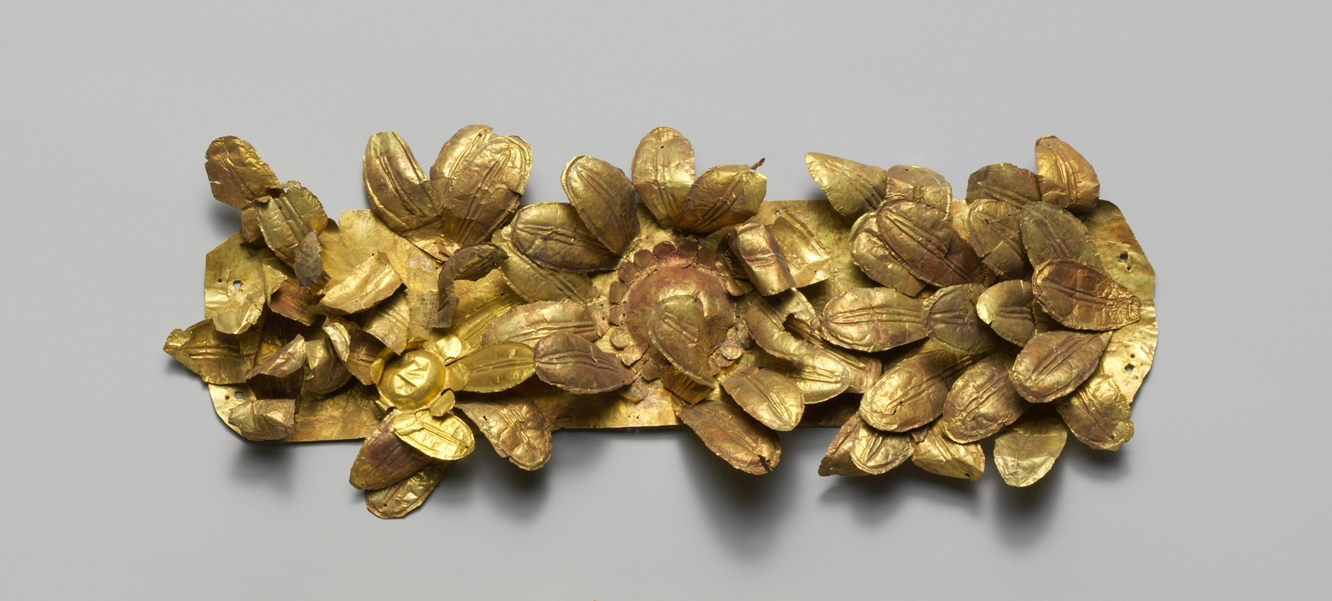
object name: wreath, funerary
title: Gold wreath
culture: etruscan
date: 400-201 BCE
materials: gold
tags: flowers,leaves